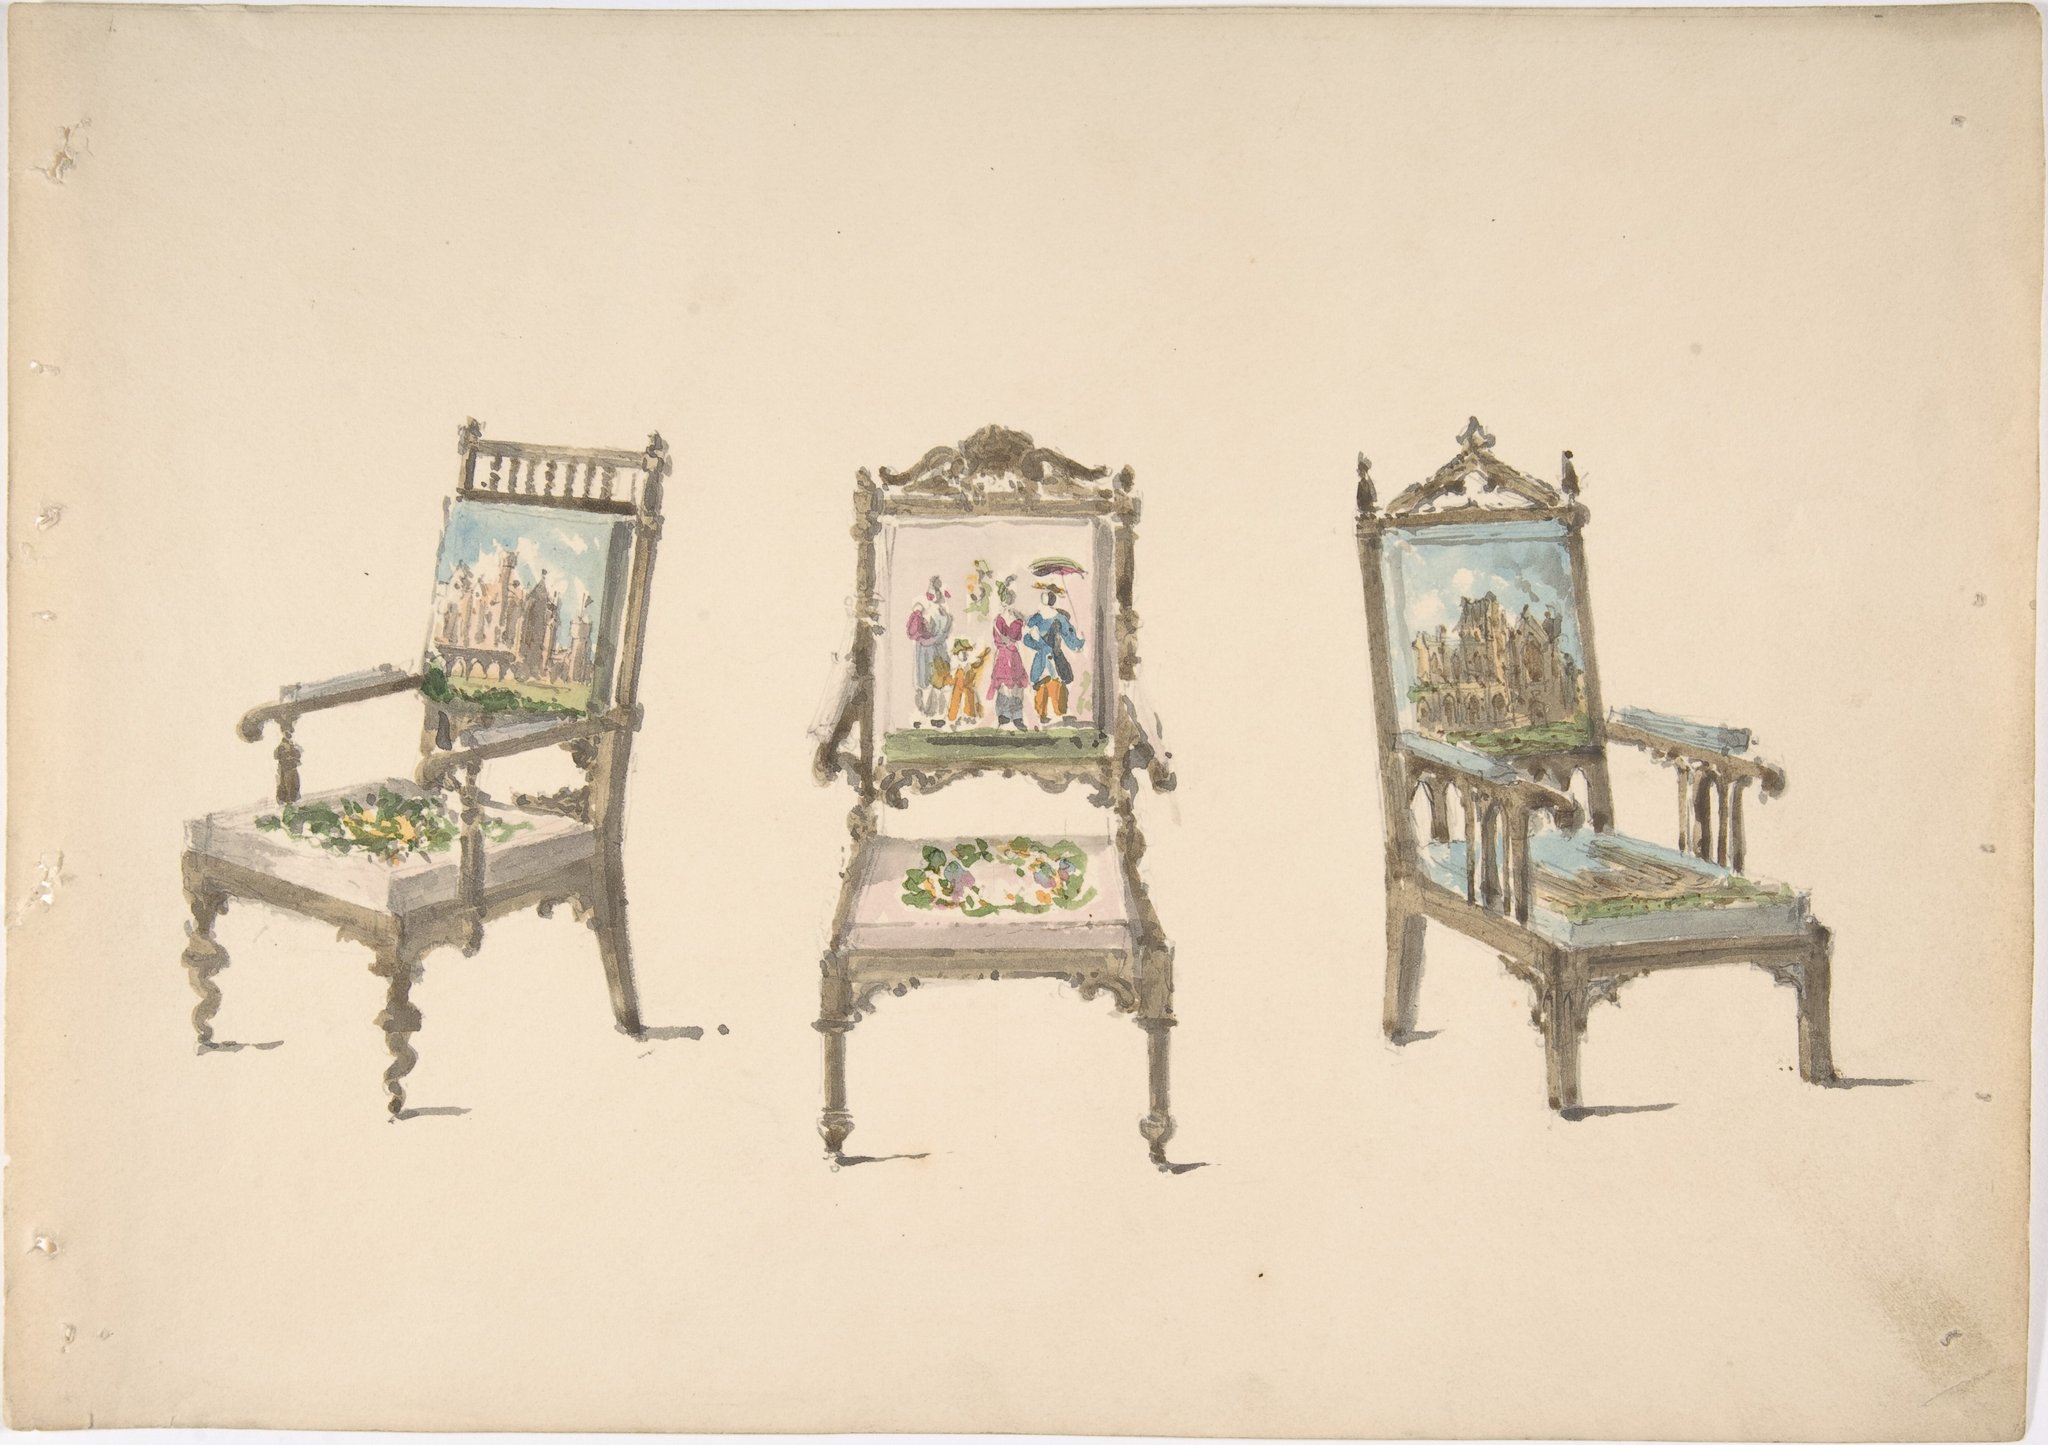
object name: drawing ornament architecture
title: Design for Three Armchairs with Pictorial Upholstery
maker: anonymous, british, 19th century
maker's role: artist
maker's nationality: british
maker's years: 1800-1900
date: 1830-1840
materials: ink, watercolor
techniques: brush, pen, wash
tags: chairs